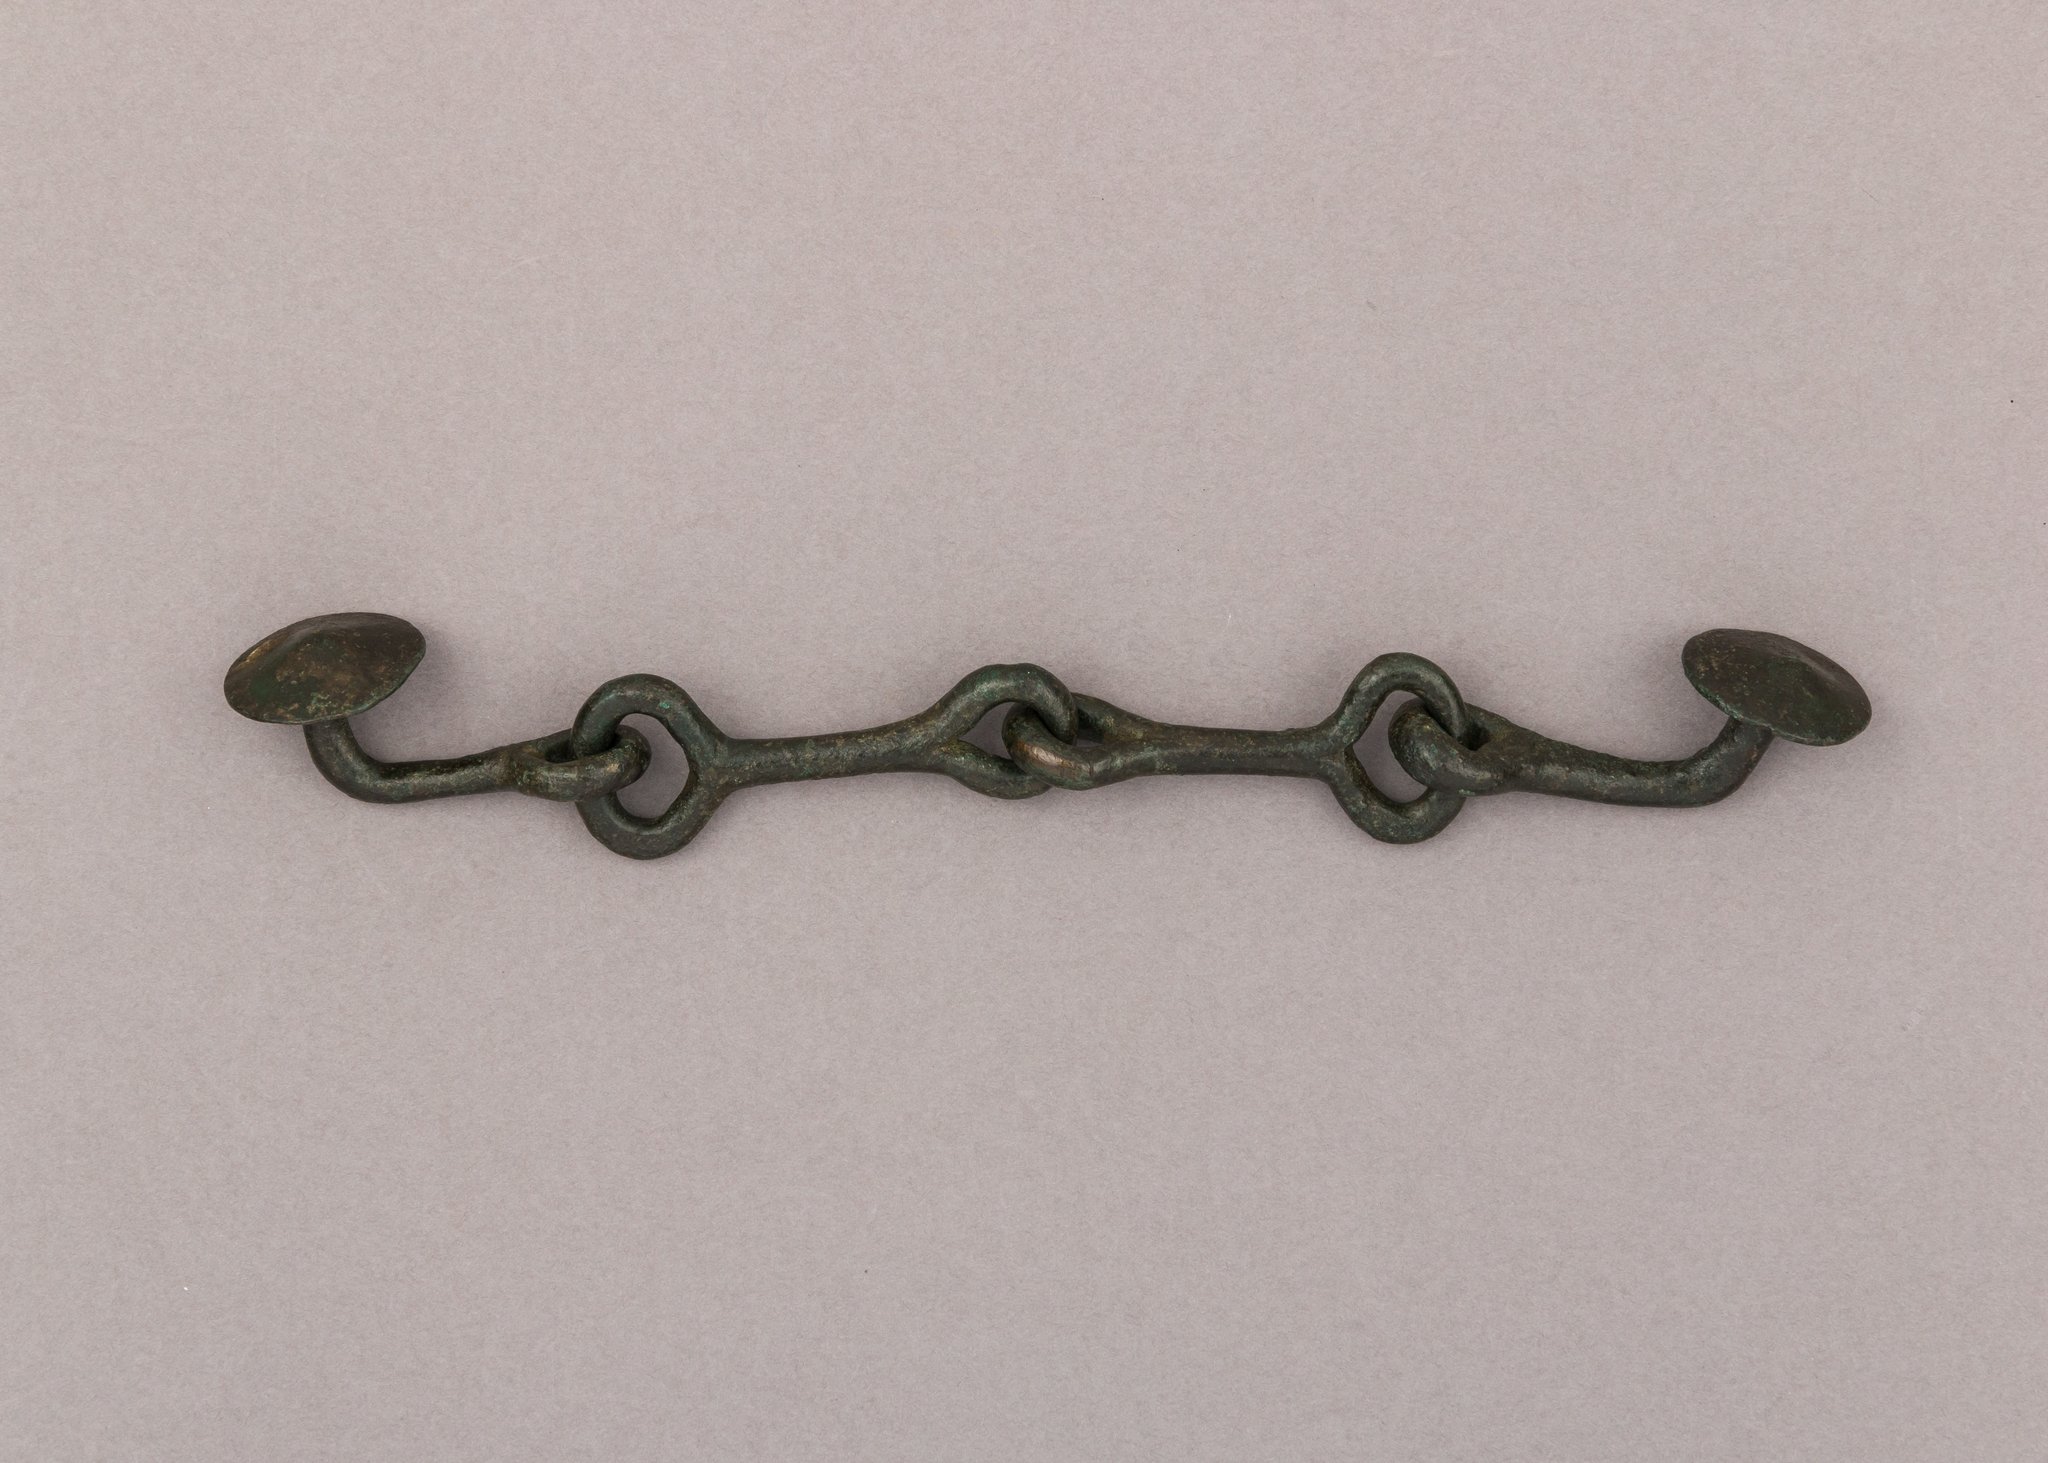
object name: bit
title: Snaffle Bit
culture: italic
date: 1100-601 BCE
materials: copper alloy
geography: italy